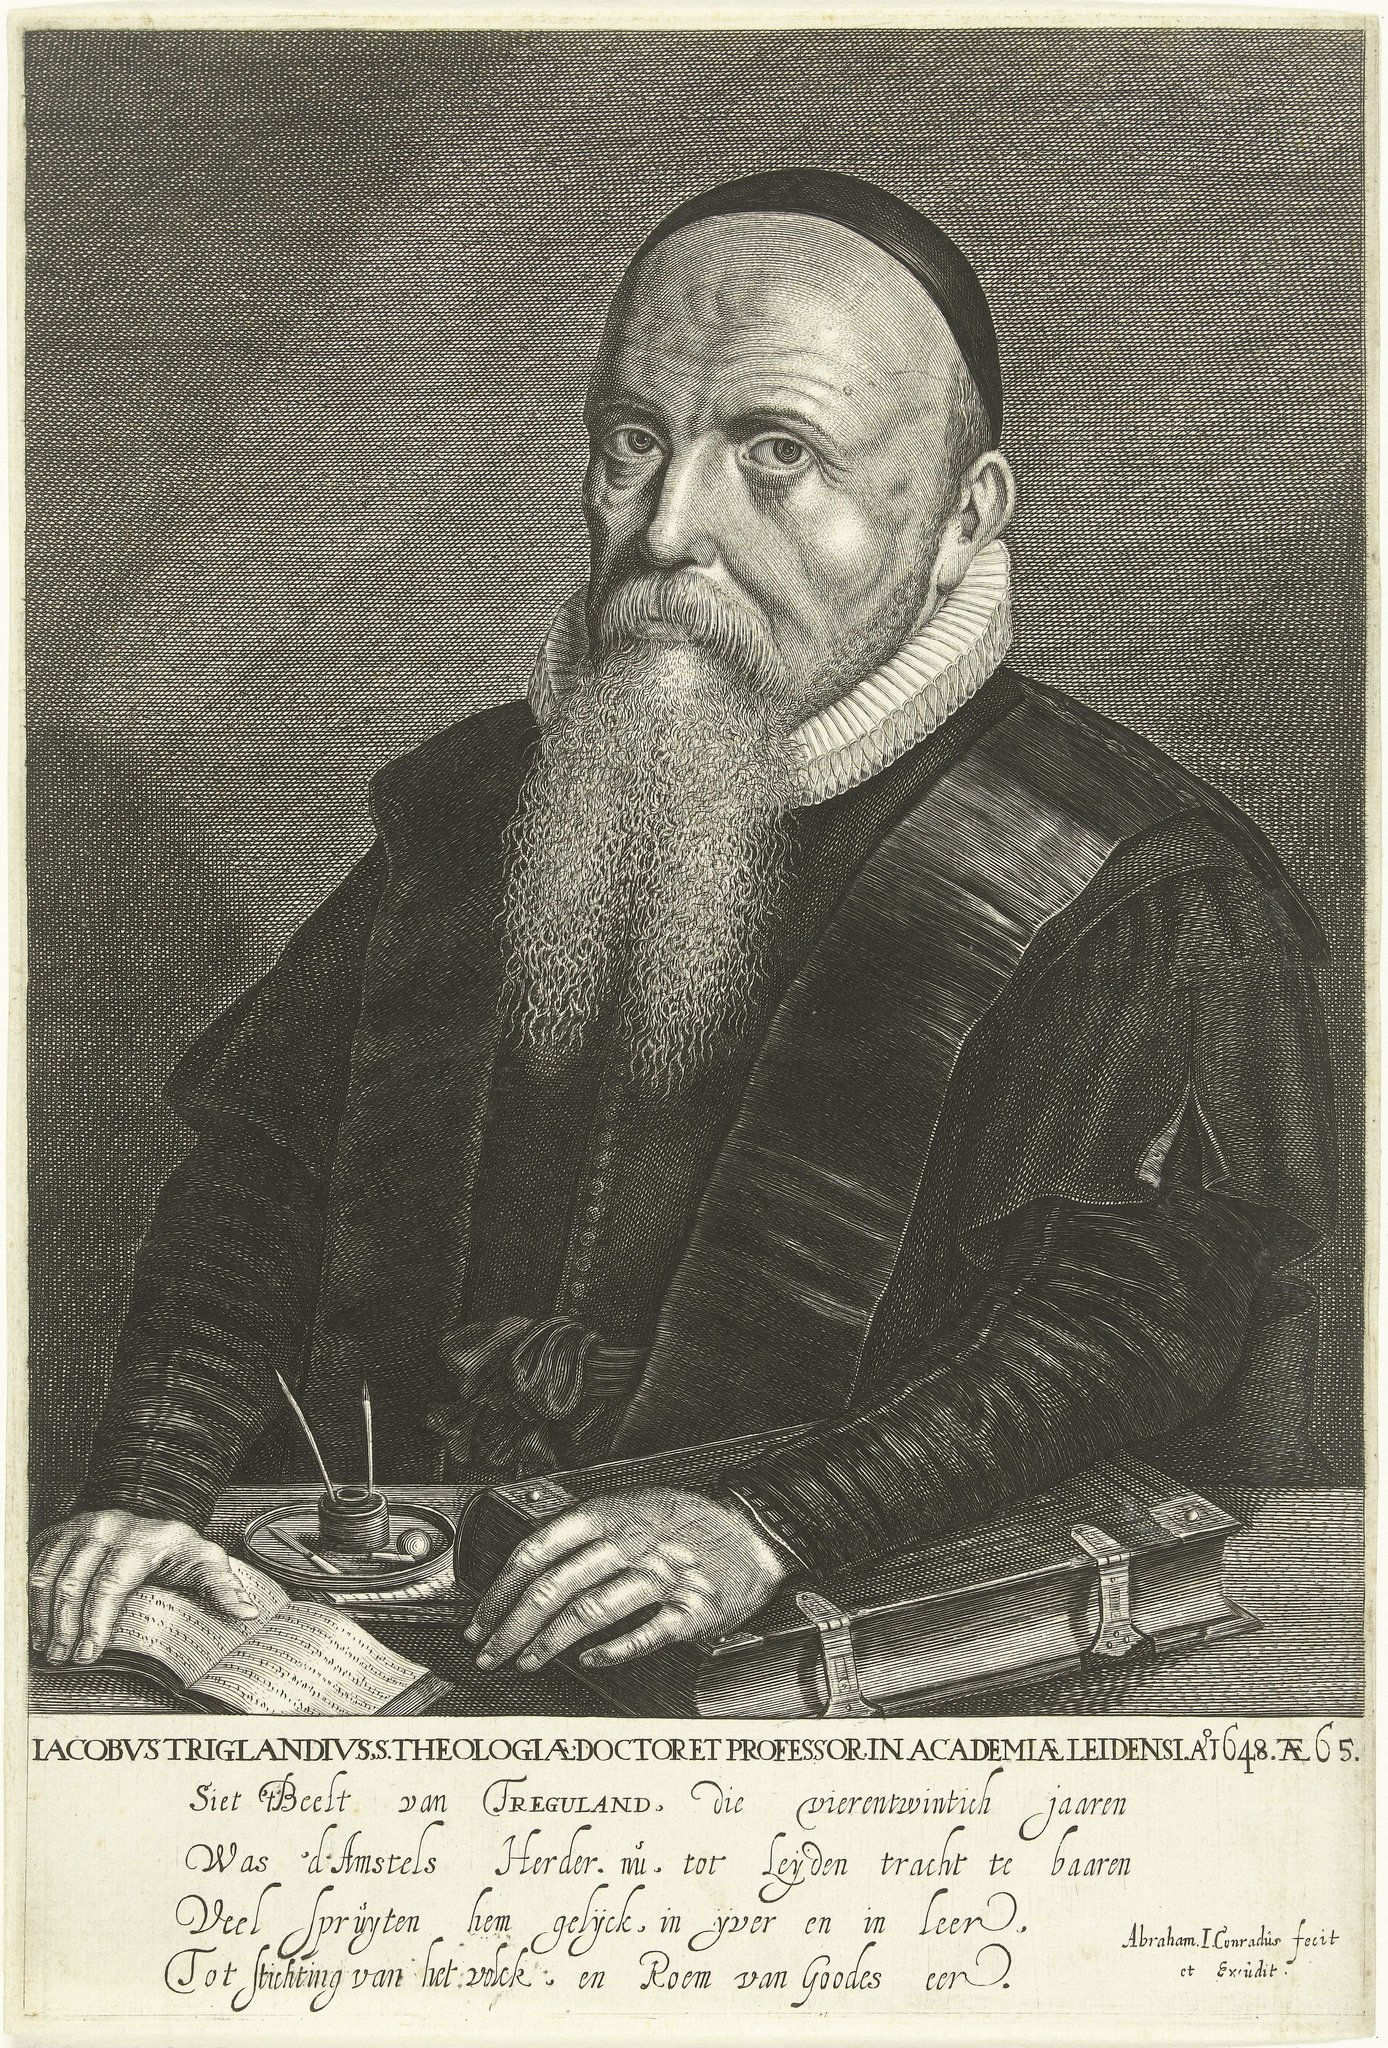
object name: print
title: Portret van Jacobus Trigland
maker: abraham j. conradus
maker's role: print maker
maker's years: 1612-1661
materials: paper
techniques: engraving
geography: amsterdam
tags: jacobus trigland (i)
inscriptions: collector's mark: Lugt 2228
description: Portret van de Leidse theoloog Jacobus Trigland. Trigland zit aan zijn schrijftafel en bladert in een boekje. Onder het portret een lofdicht op Trigland.